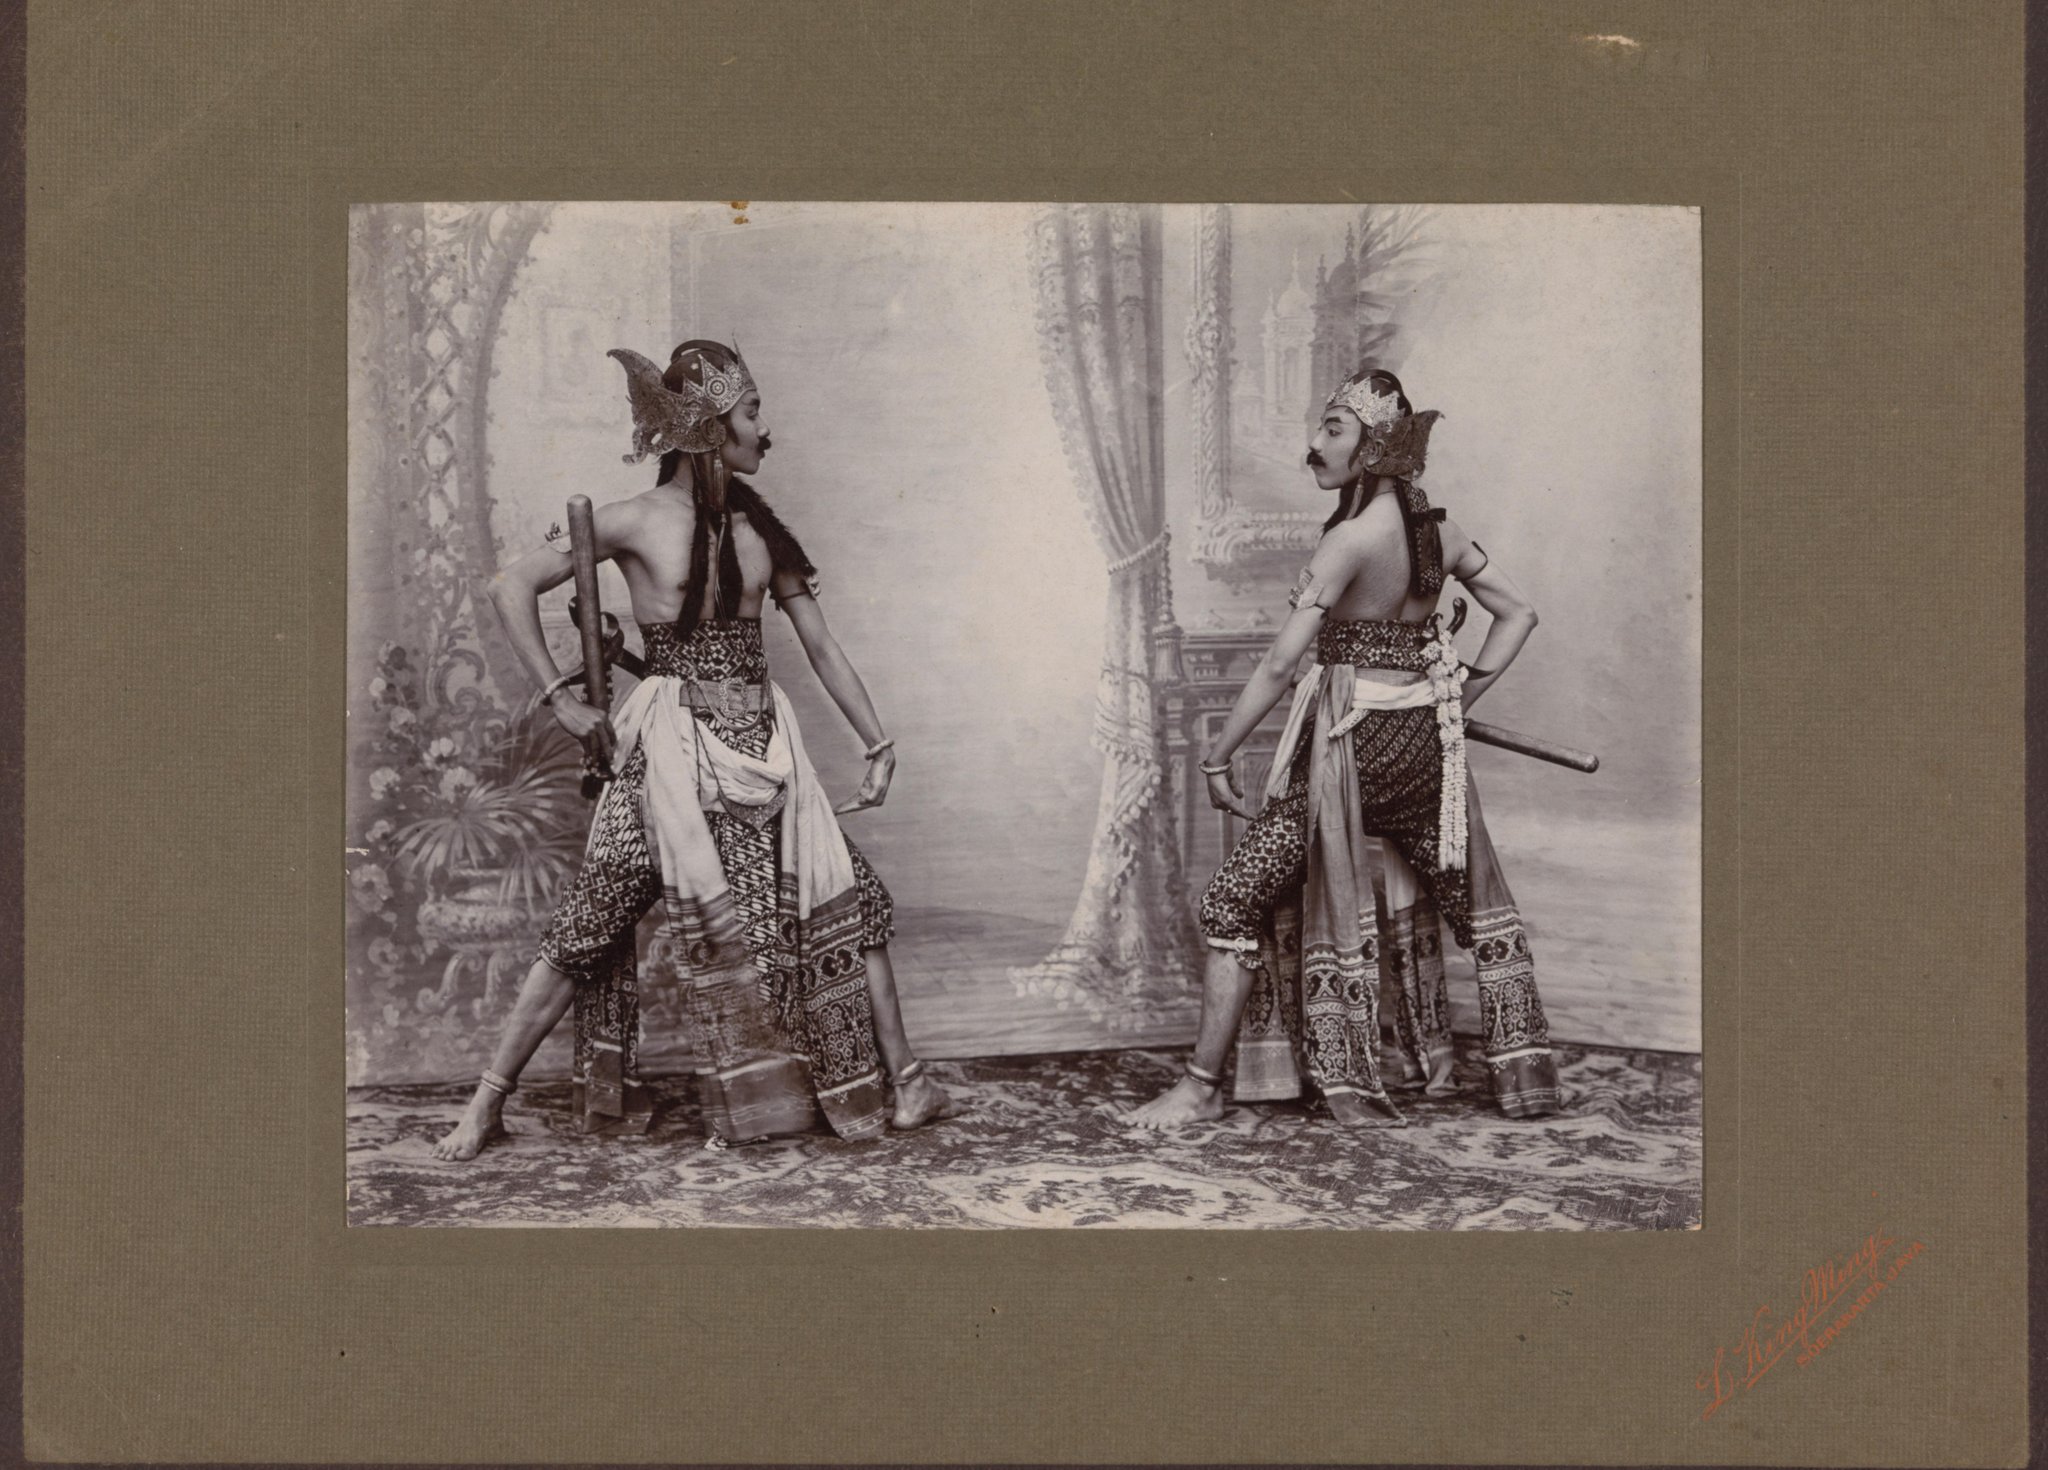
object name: album leaf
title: Javaanse hofdansers (Soera Karta)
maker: l. king ming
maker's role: fotograaf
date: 1860-1915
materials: cardboard, paper, photographic support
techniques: collodion silver print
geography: dutch east indies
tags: dutch east indies, the